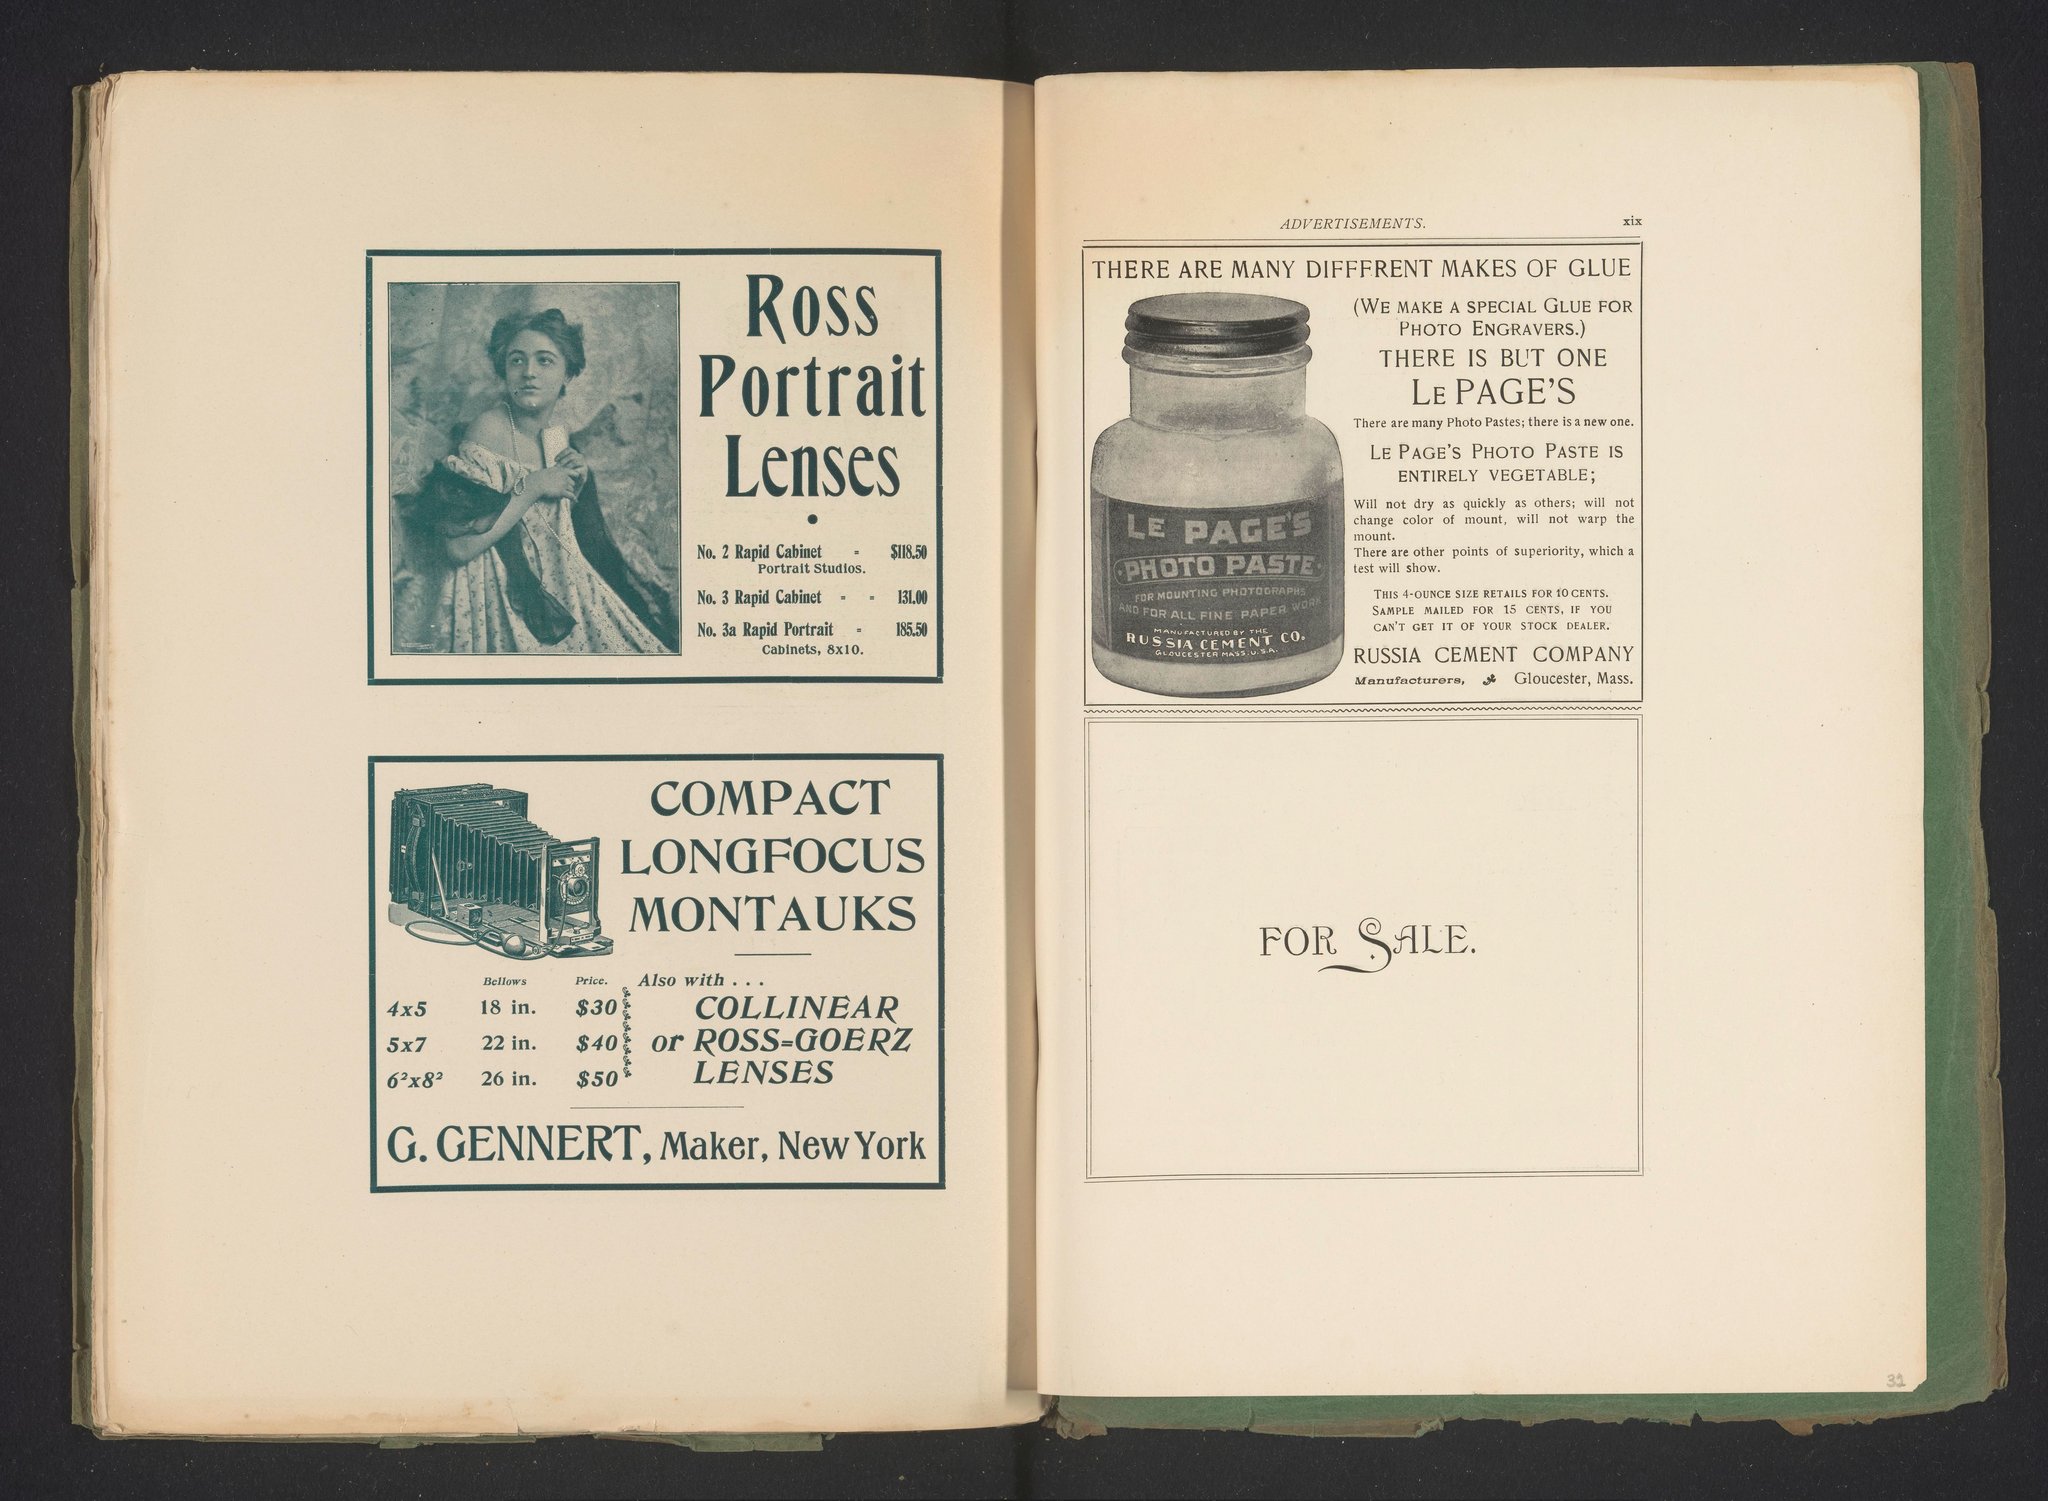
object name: photomechanical print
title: Pot fotolijm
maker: Anonymous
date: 1895-1900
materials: paper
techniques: autotype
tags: container of glass: bottle, jar, vase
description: Prent op pagina xix. Prent is onderdeel van een reclameboodschap van Russia Cement Company.